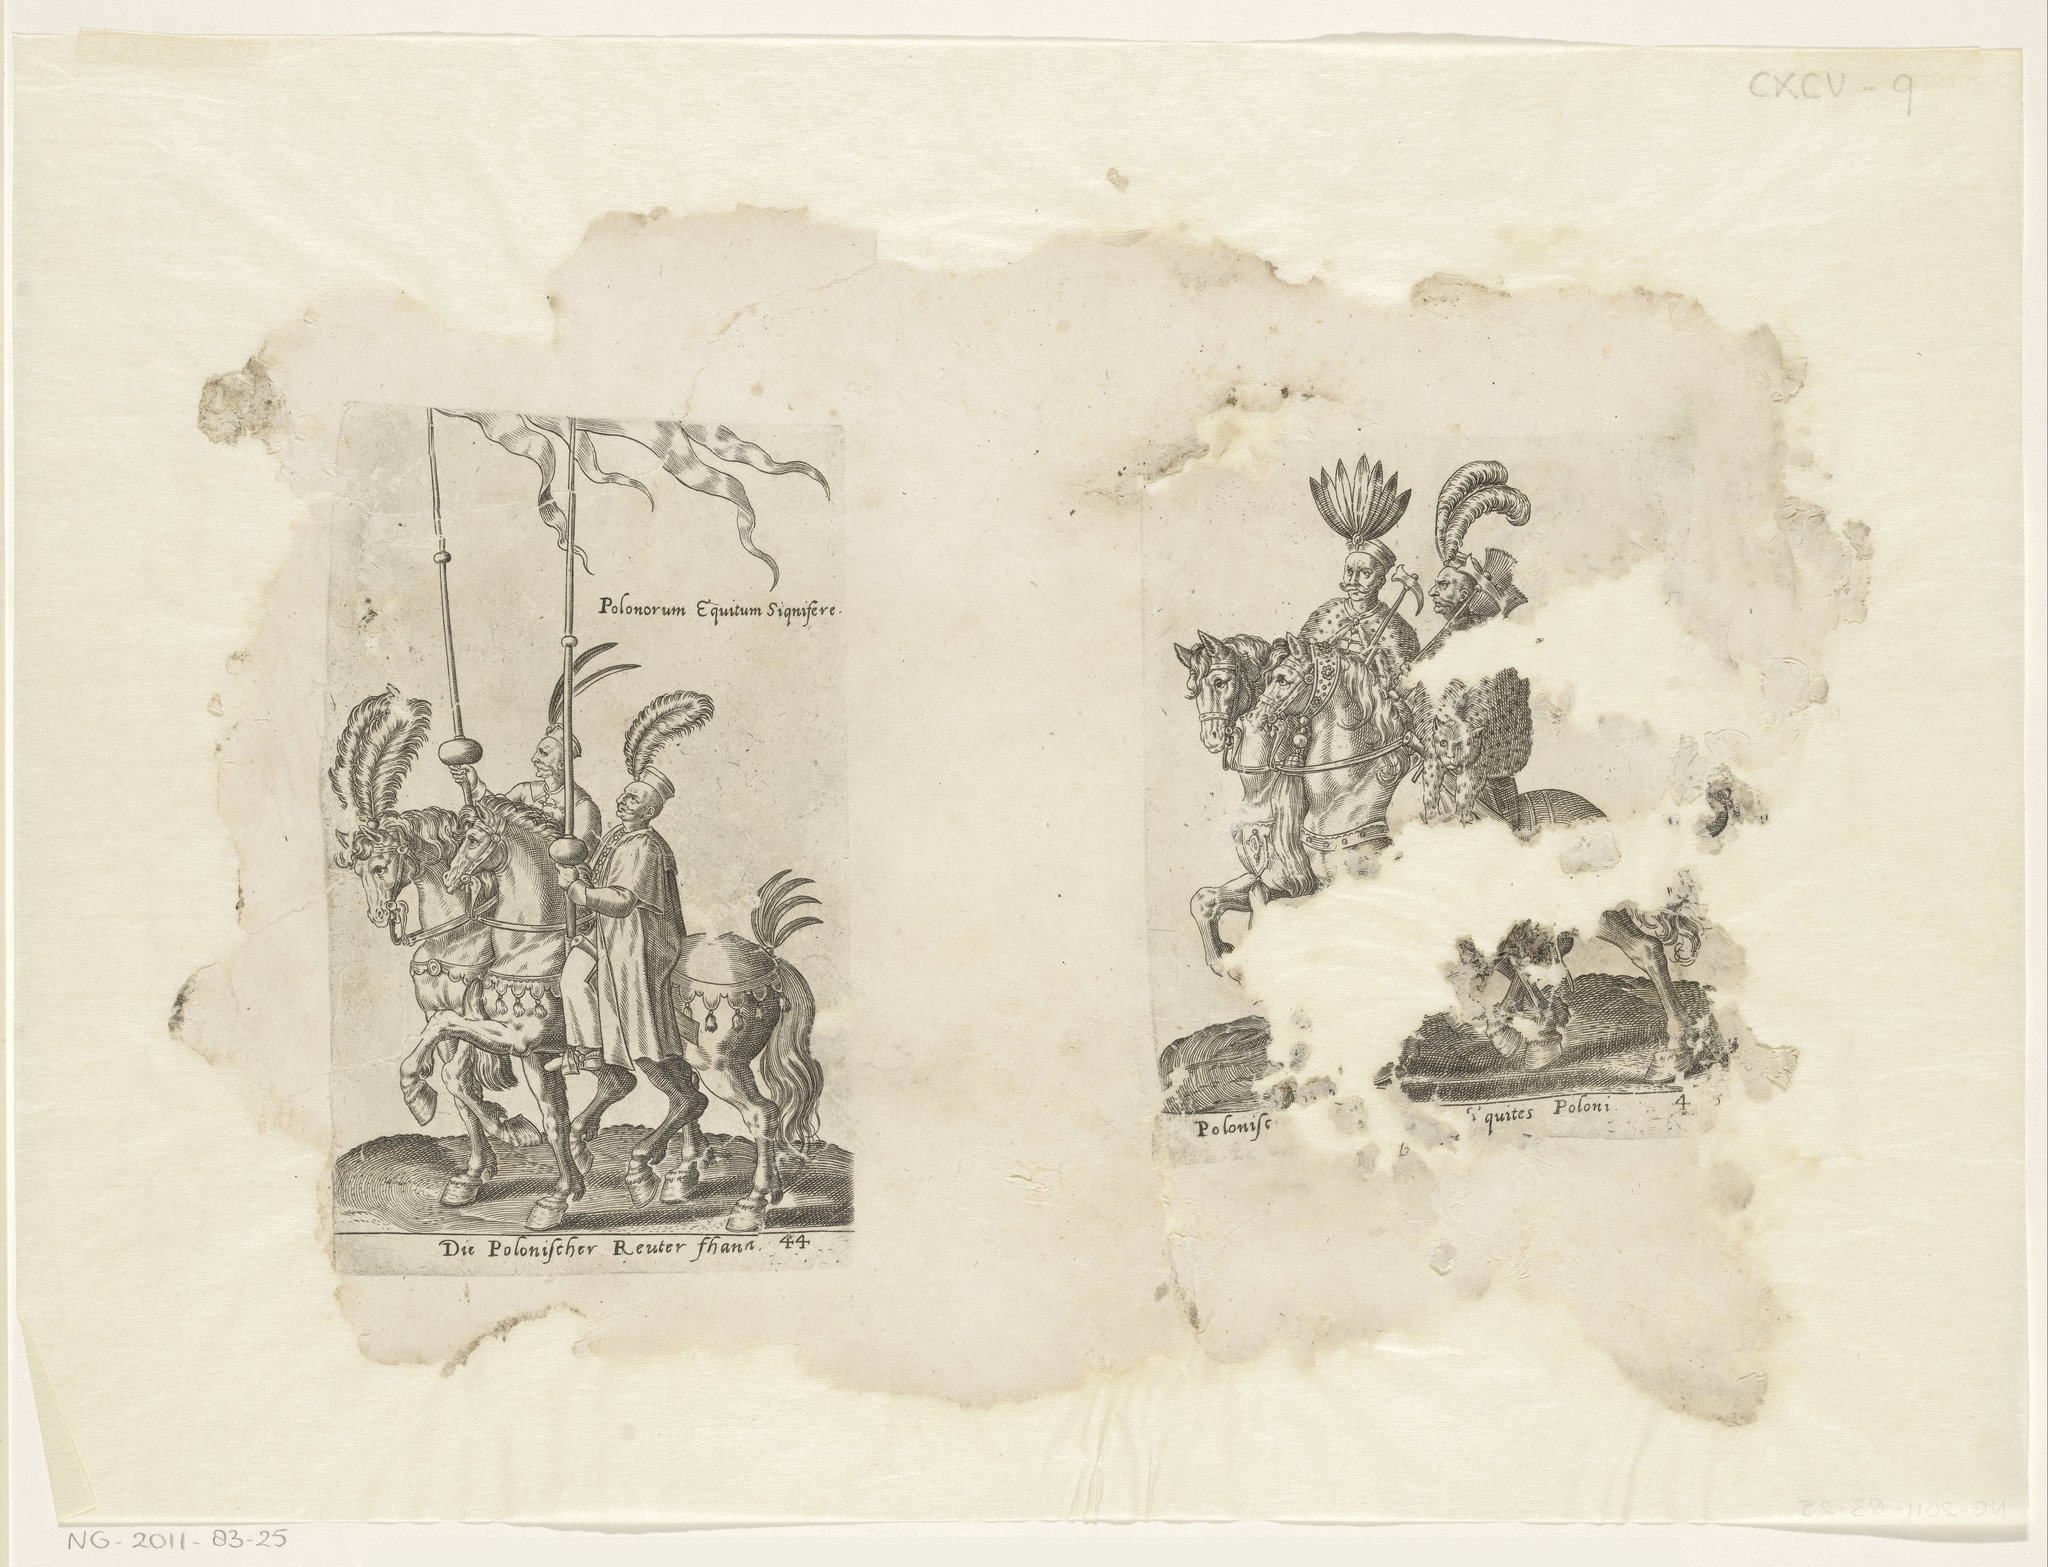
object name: print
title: Poolse vaandeldragers en Poolse ruiters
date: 1576-1596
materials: paper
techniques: engraving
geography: cologne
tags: warfare; military affairs (+ cavalry, horsemen), folk costume, regional costume, military clothing and other equipment (uniforms, cap, armour, helmet, etc.)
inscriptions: watermark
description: Prent 44 en 45 uit een serie van 77, mogelijke serietitel Diversarum gentium armatura Equestris. Latere editie van serie Equitum Descripcio, Quomodo Equestres (...). De prenten in de Nova Zembla collectie zijn tijdens een expeditie van Willem Barendsz en Jacob van Heemskerk in 1596-1597 noodgedwongen in het winterkamp, het ‘Behouden Huis’, op het eiland achtergelaten. De prenten waren in één of meerdere stapels als handelswaar meegenomen vanuit Amsterdam. Bijna drie eeuwen later, in 1871, keerde de Noor Elling Carlsen terug naar Nova Zembla en vond daar de restanten van het ‘Behouden Huis, inclusief een groot deel van de inventaris. Een deel van de prenten, in de vorm van aaneengekoekte kluiten, werd toen ook teruggevonden. De papierkluiten waren soms op meerdere plekken gebroken. Tussen 1975-1979 zijn de prenten van elkaar gescheiden. Dit leverde in totaal ca. 1000 fragmenten van ca. 400 afdrukken van ca. 150 verschillende prenten op. Voor zover mogelijk zijn de fragmenten samengevoegd en zijn de prenten gereconstrueerd.